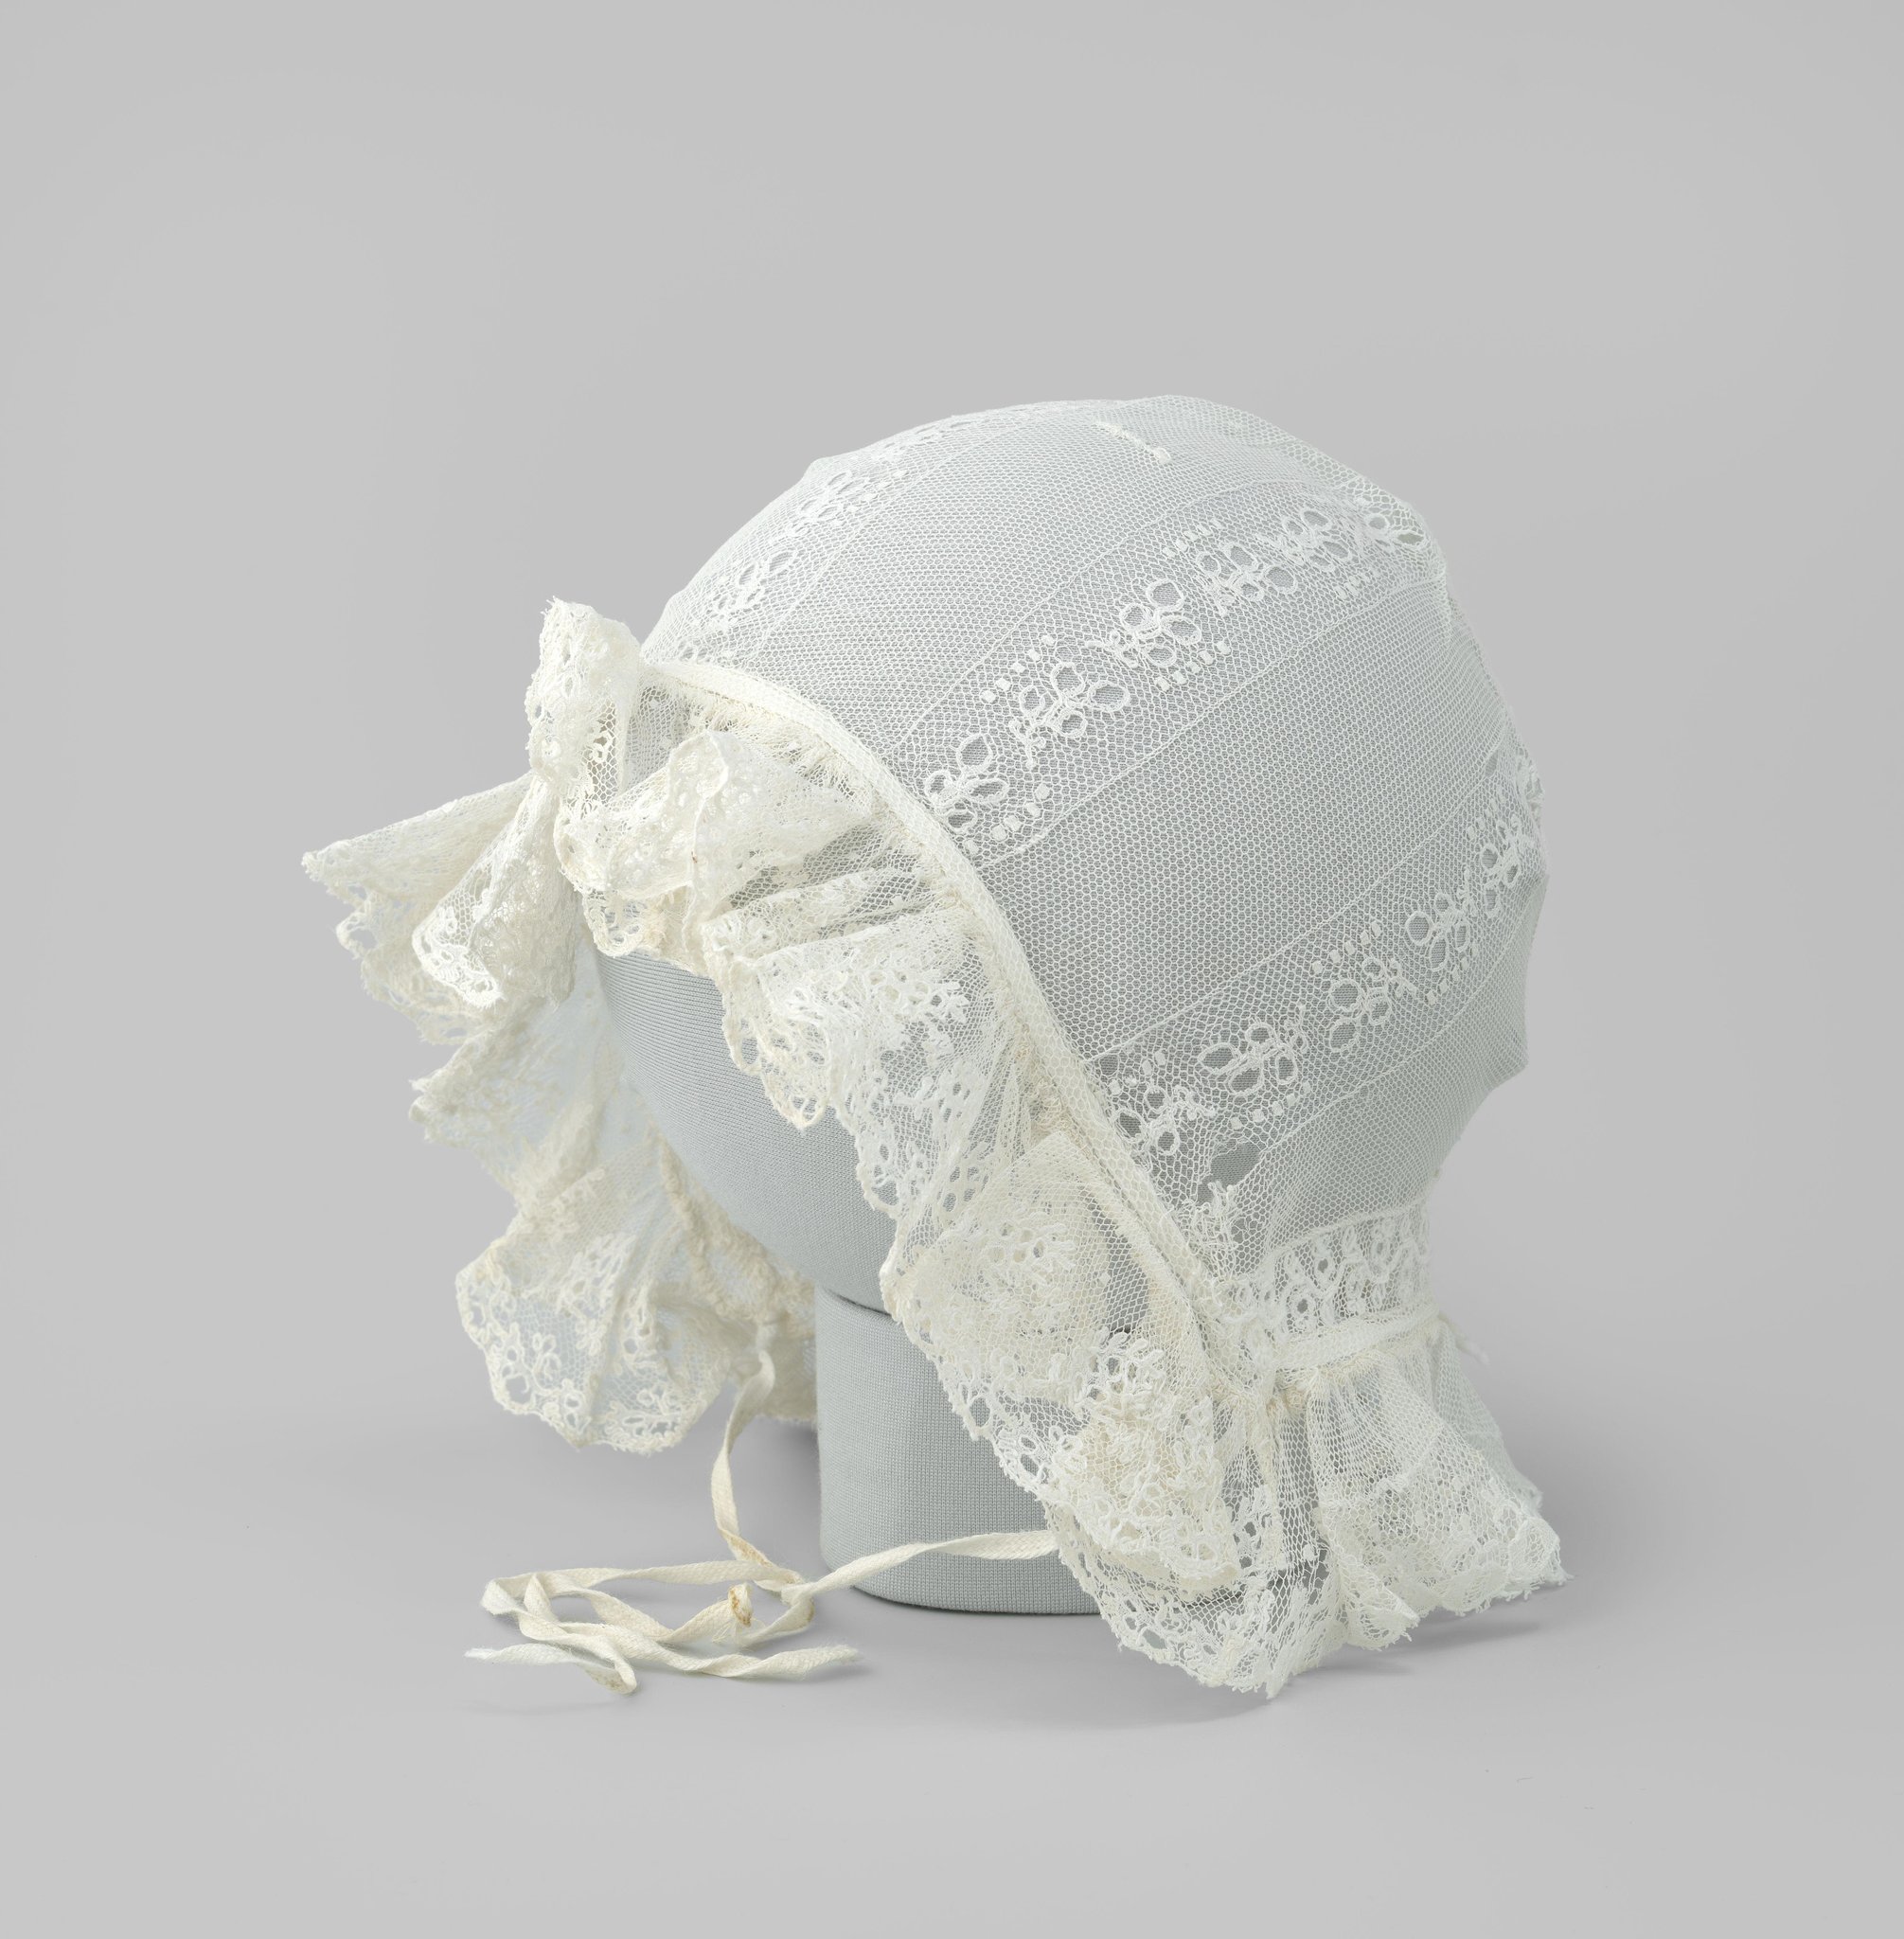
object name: babymuts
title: Babymuts van witte tule afgezet met een gerimpeld aangezette strook geschulpte kant en een strik van twee witte linten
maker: Anonymous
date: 1800-1900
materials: lace, fiber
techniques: embroidered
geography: netherlands